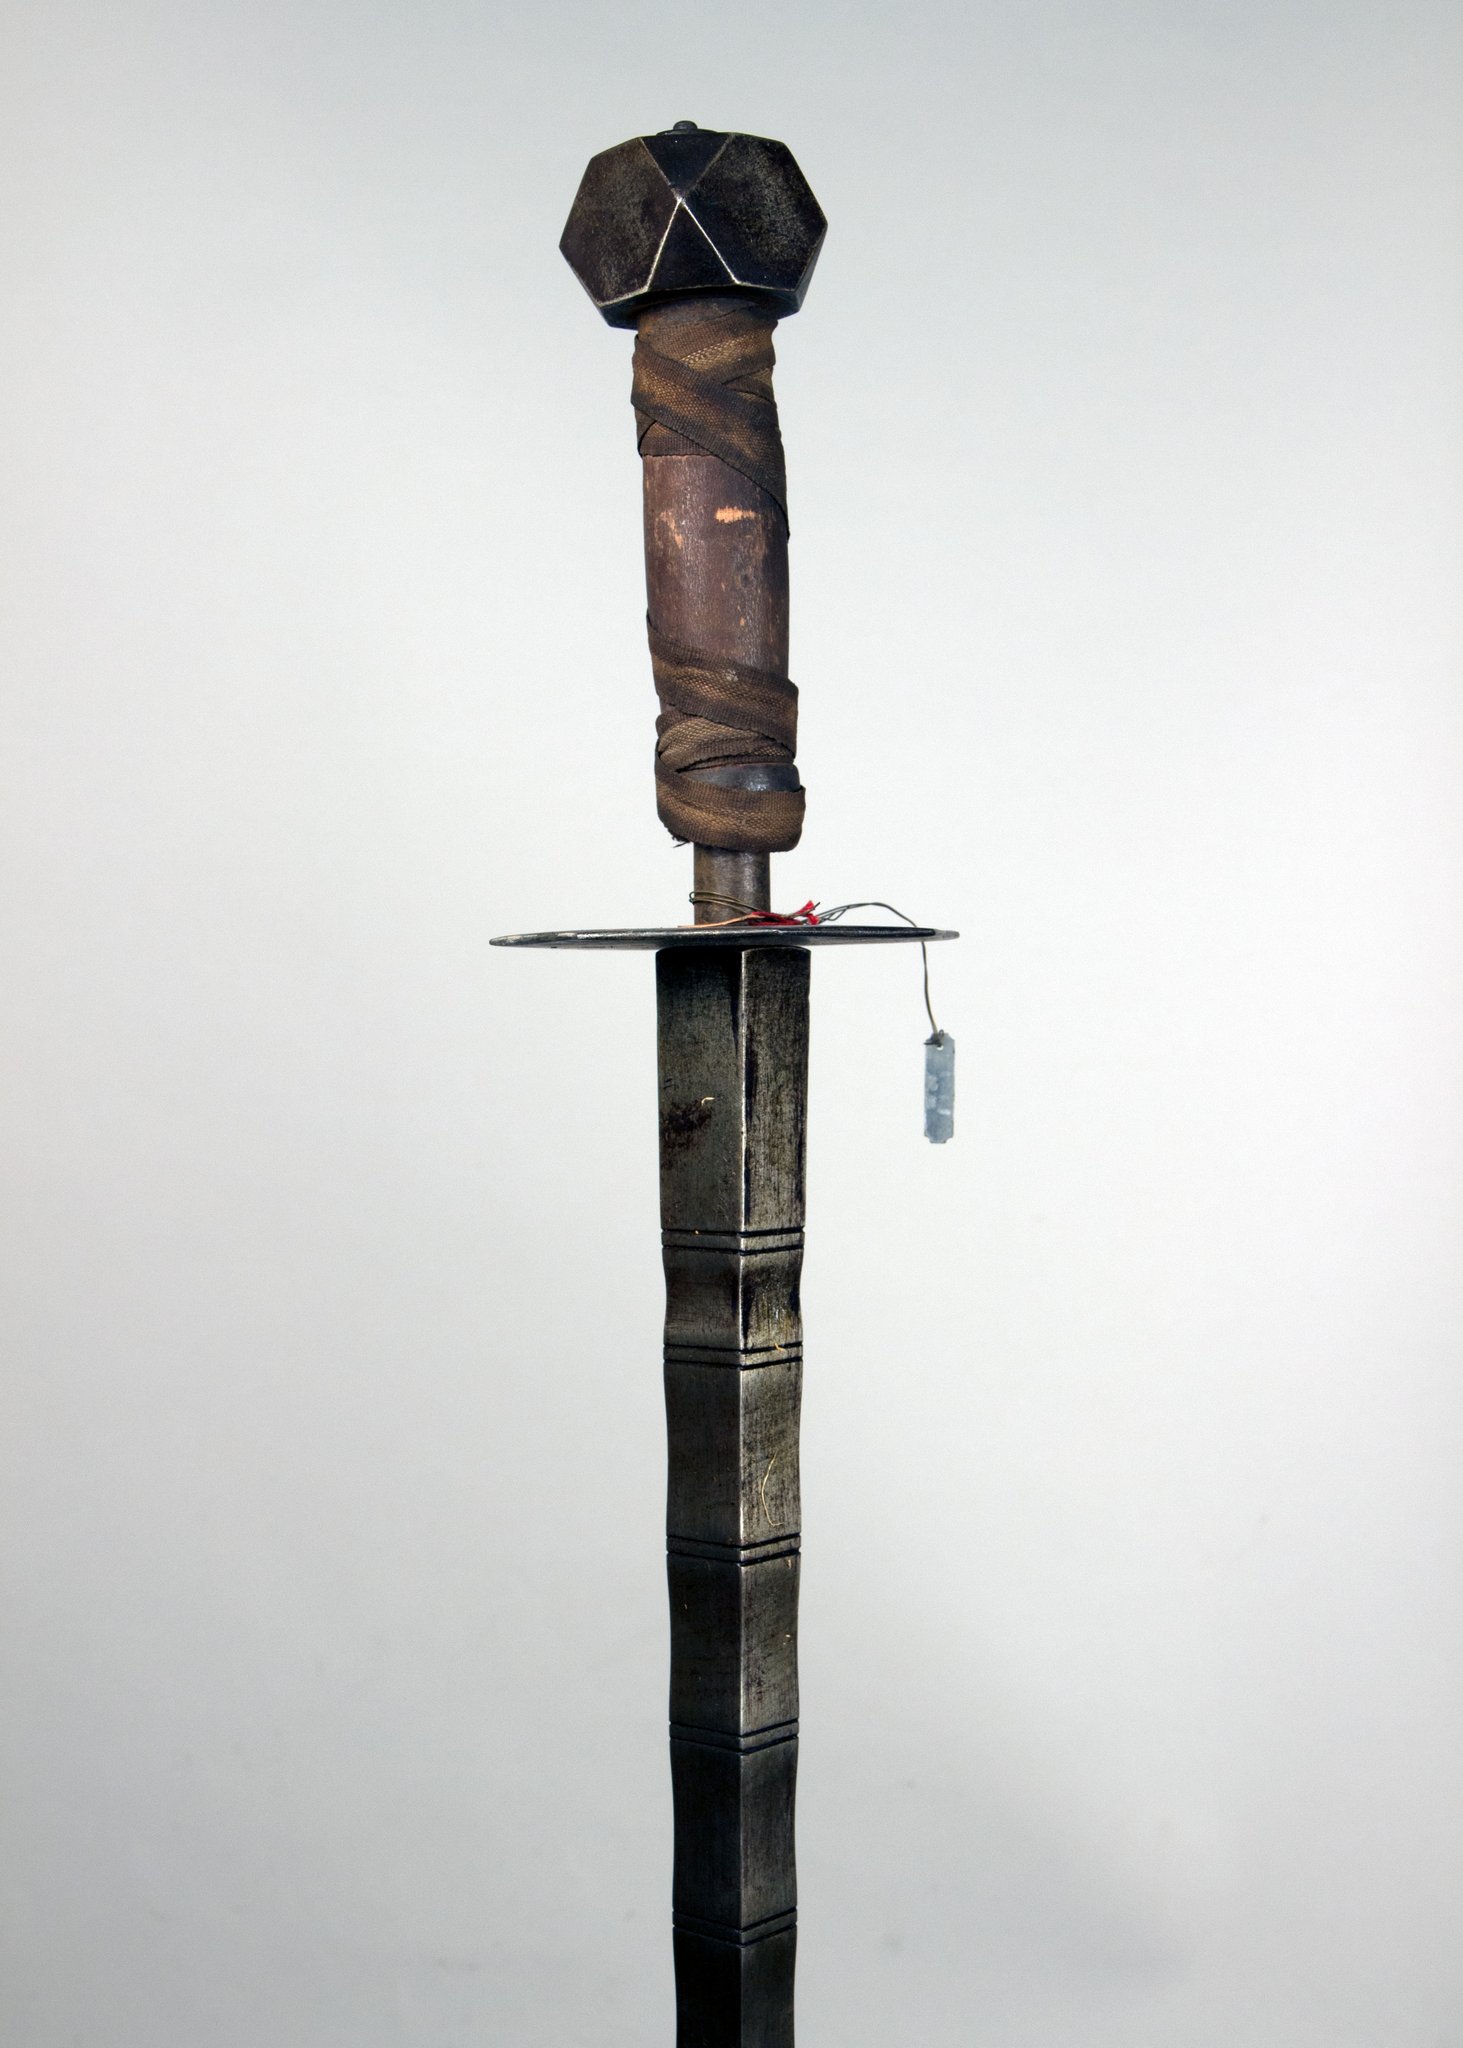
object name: mace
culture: chinese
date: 1701-1900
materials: steel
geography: china